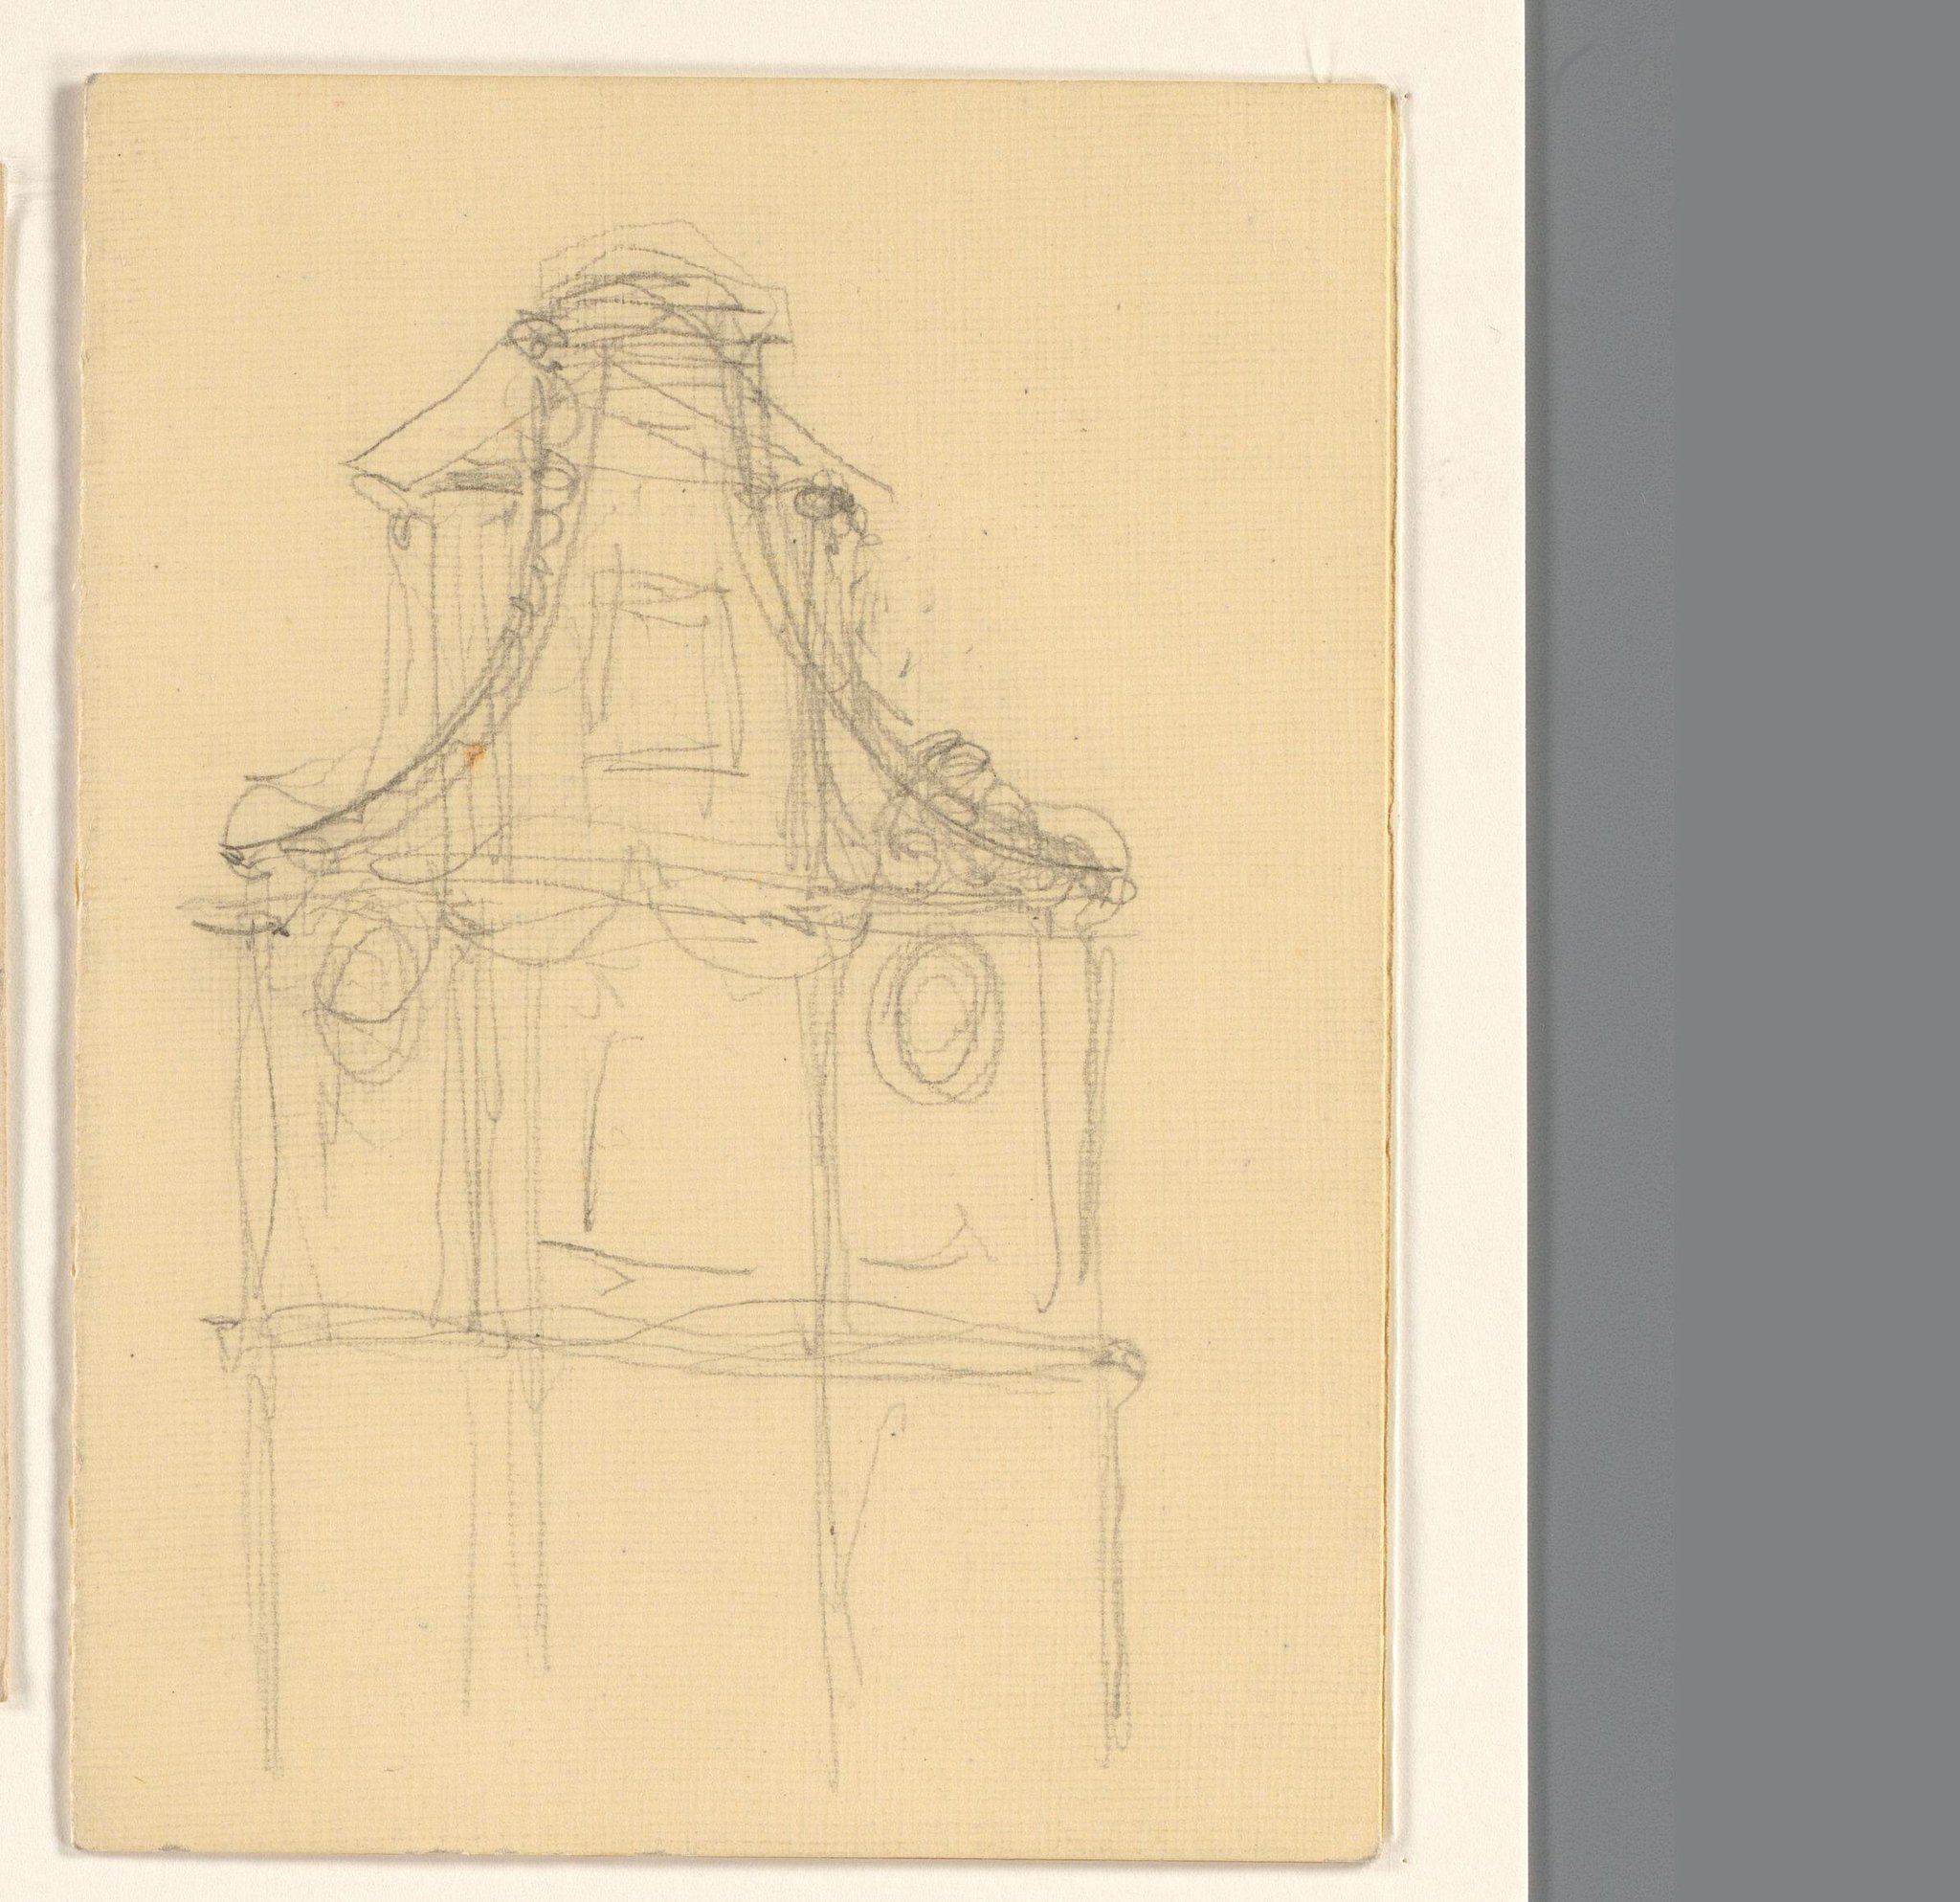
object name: drawing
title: Architectuurschets van een gevel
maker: august allebé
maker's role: draughtsman, print maker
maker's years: 1838-1927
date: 1848-1927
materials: paper, pencil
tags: façade (of house or building)